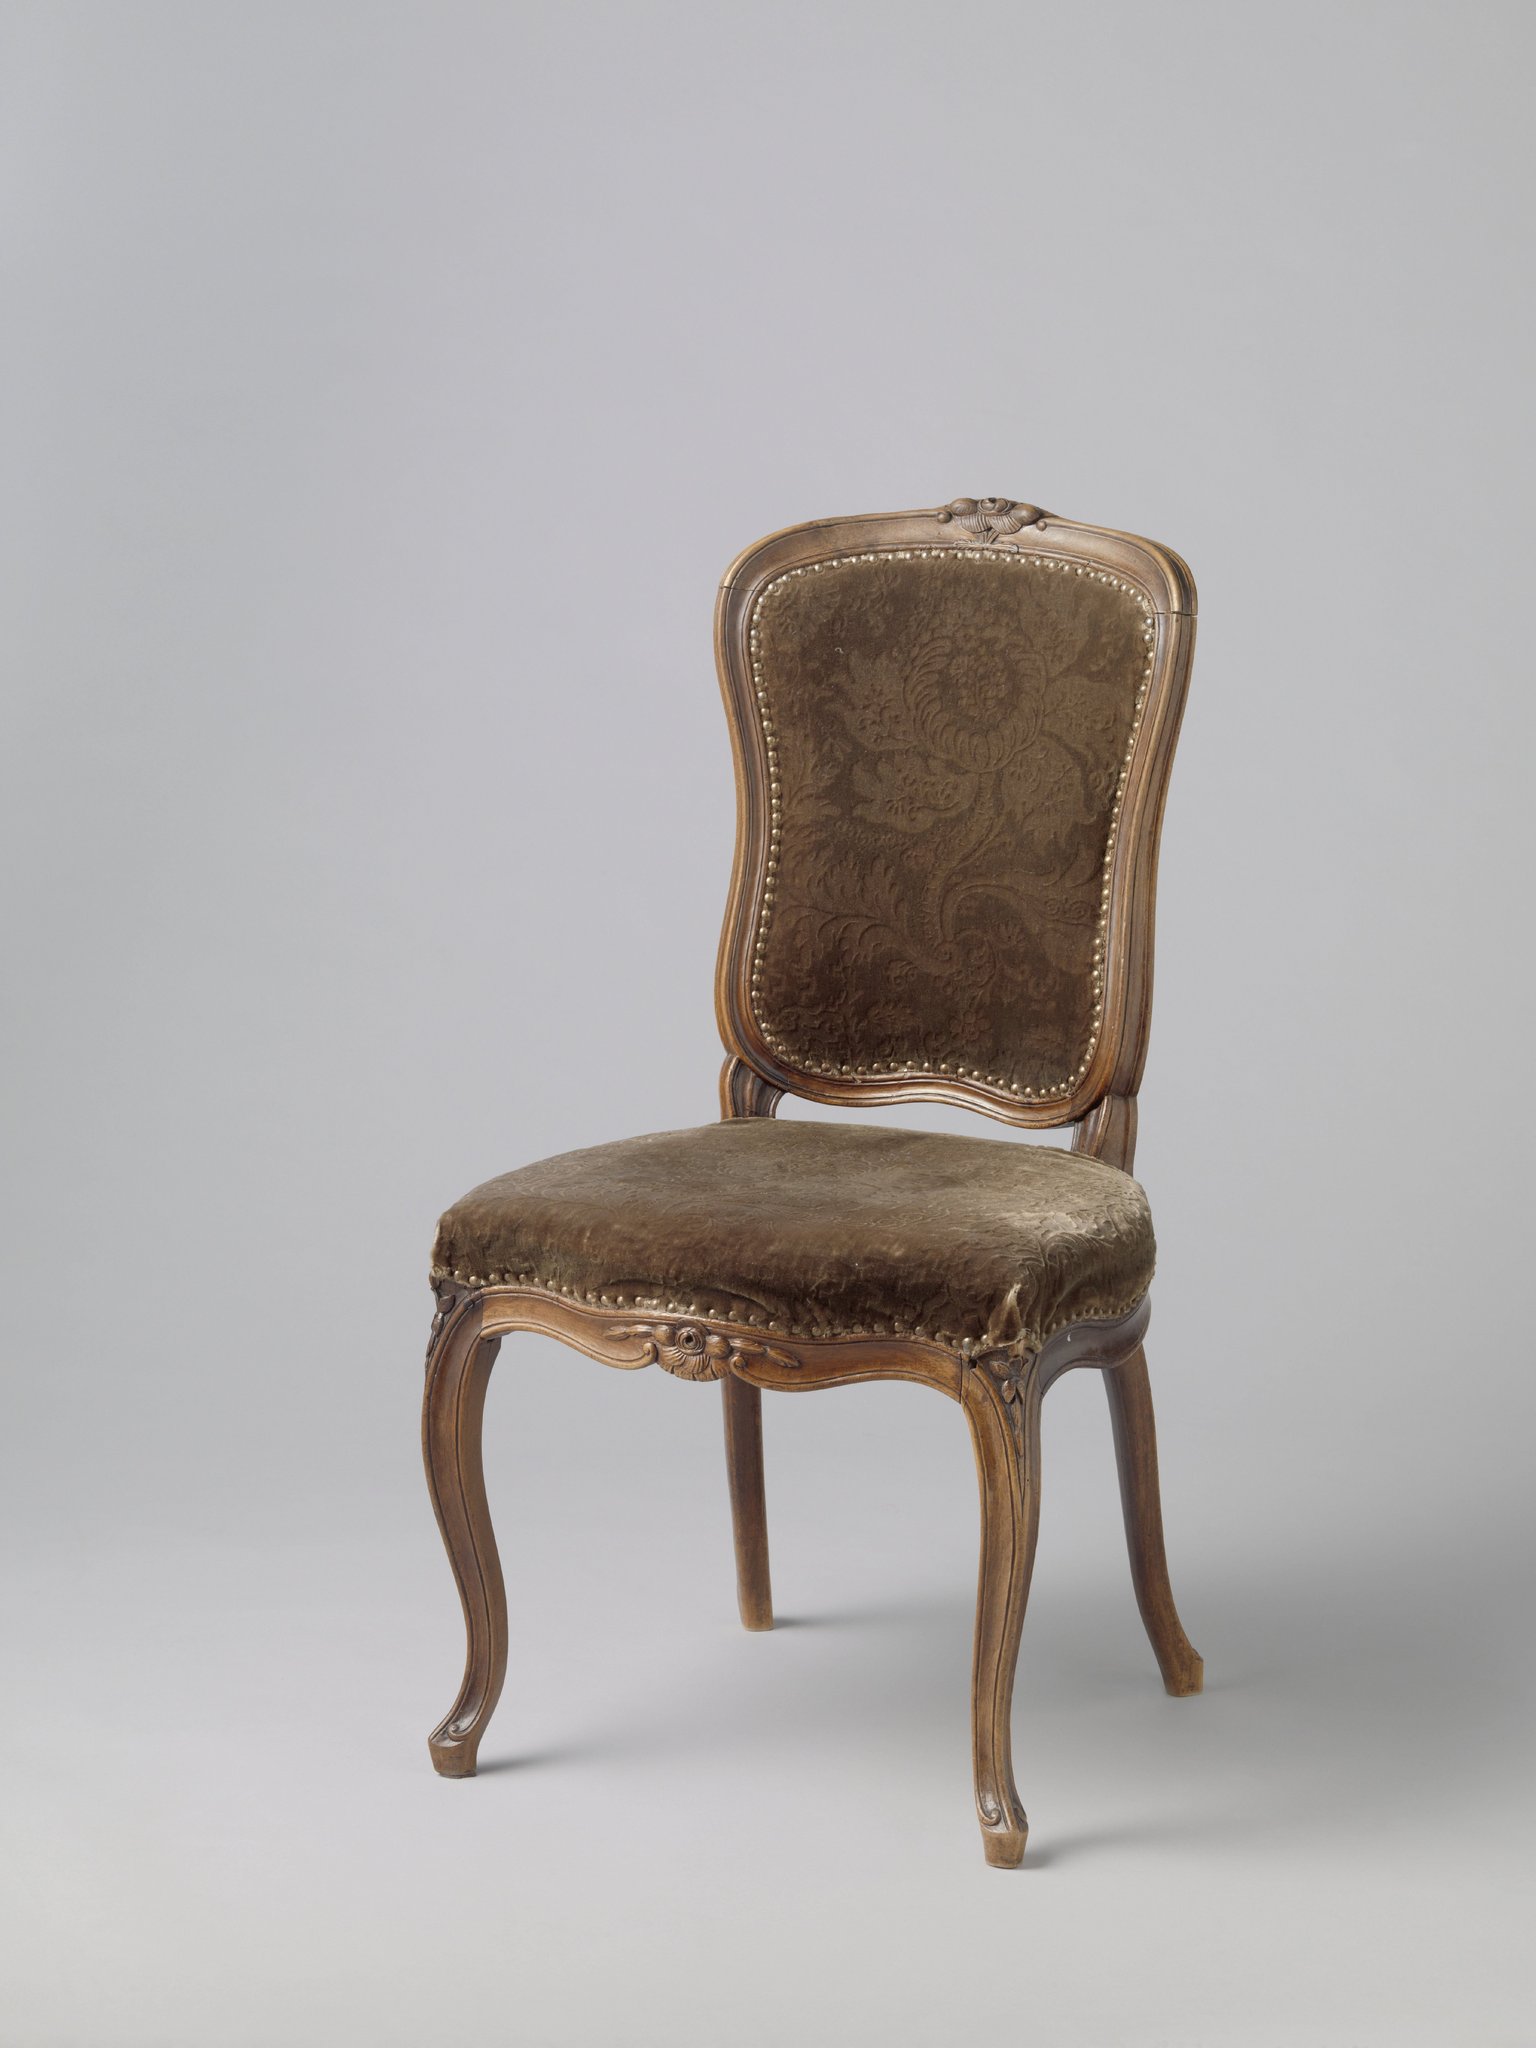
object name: furniture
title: Stoel van notenhout met beklede zitting, op overhoeks geplaatste gestrekt S-vormige poten op bokshoeven die in het zitraam overgaan. Voorzien van snijwerk.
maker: Anonymous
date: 1740-1760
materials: textile, wood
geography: northern netherlands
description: Stoel behorende tot ameublement bestaande uit zes beklede notenhouten stoelen en één armstoel, rustend op overhoeks geplaatste gestrekt S-vormige poten op bokshoeven, die in het zitraam overgaan. Het geronde, aan de voorkant geschulpte, zitraam draagt versieringen in bloemmotief; evenals de bovendorpel van het langwerpige beklede rugraam dat van onderen en van opzij iets geschulpt is. De gestrekt S-vormige armleggers worden gesteund door achterwaarts geplaatste gestrekt S-vormige stutten met voluut- en acanthusbladversiering.